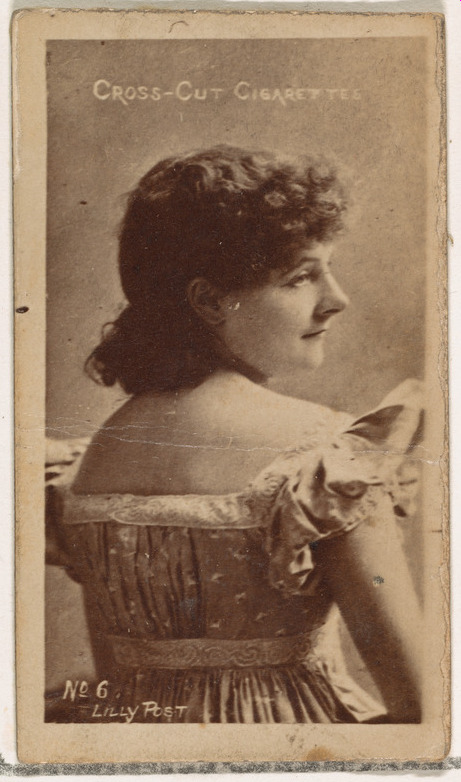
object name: print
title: Card Number 6, Lilly Post, from the Actors and Actresses series (N145-1) issued by Duke Sons & Co. to promote Cross Cut Cigarettes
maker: w. duke, sons & co.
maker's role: publisher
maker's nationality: american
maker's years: 1870-1920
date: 1880-1889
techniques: albumen silver print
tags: women,actresses